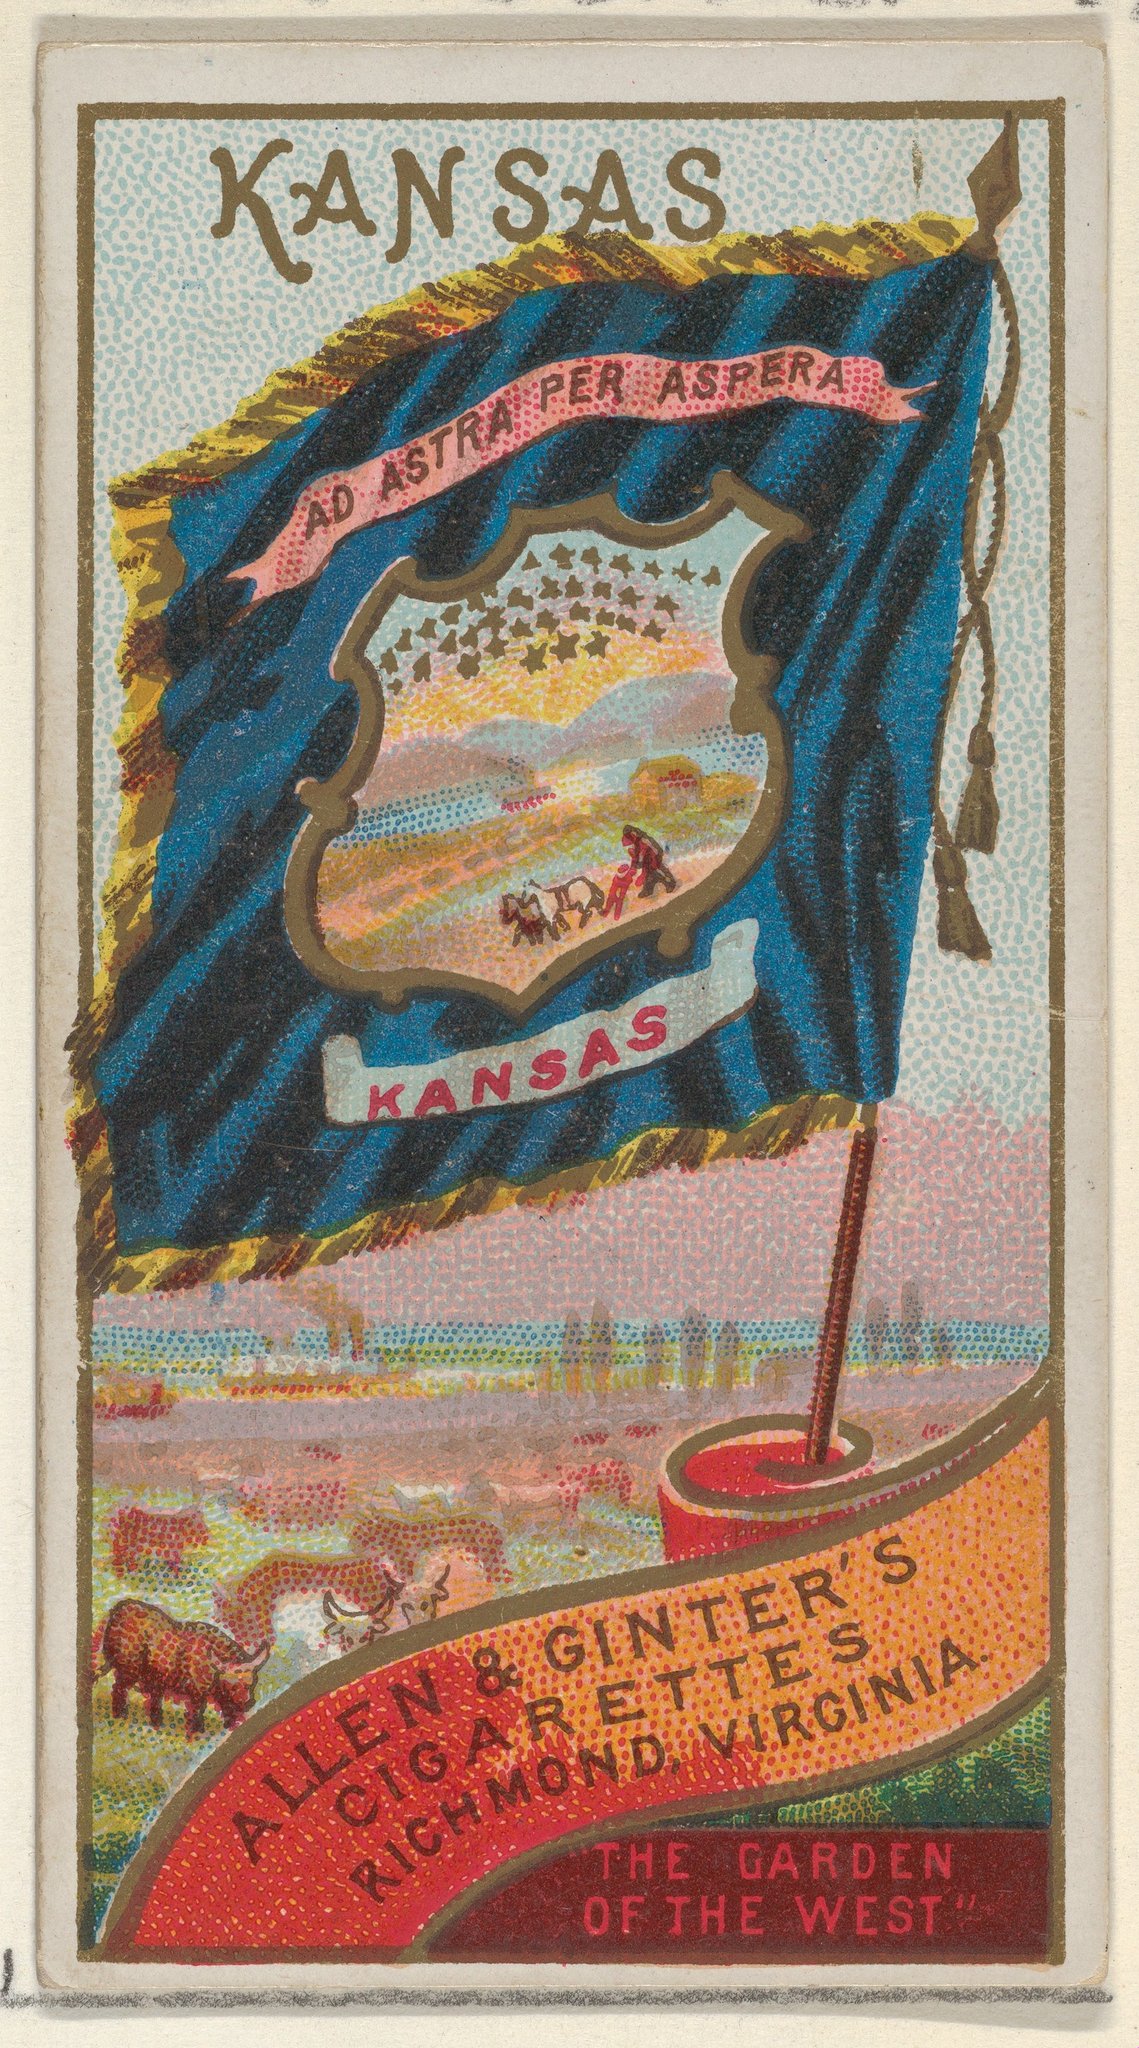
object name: print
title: Kansas, from Flags of the States and Territories (N11) for Allen & Ginter Cigarettes Brands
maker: allen & ginter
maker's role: publisher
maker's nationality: american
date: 1888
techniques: color lithograph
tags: flags